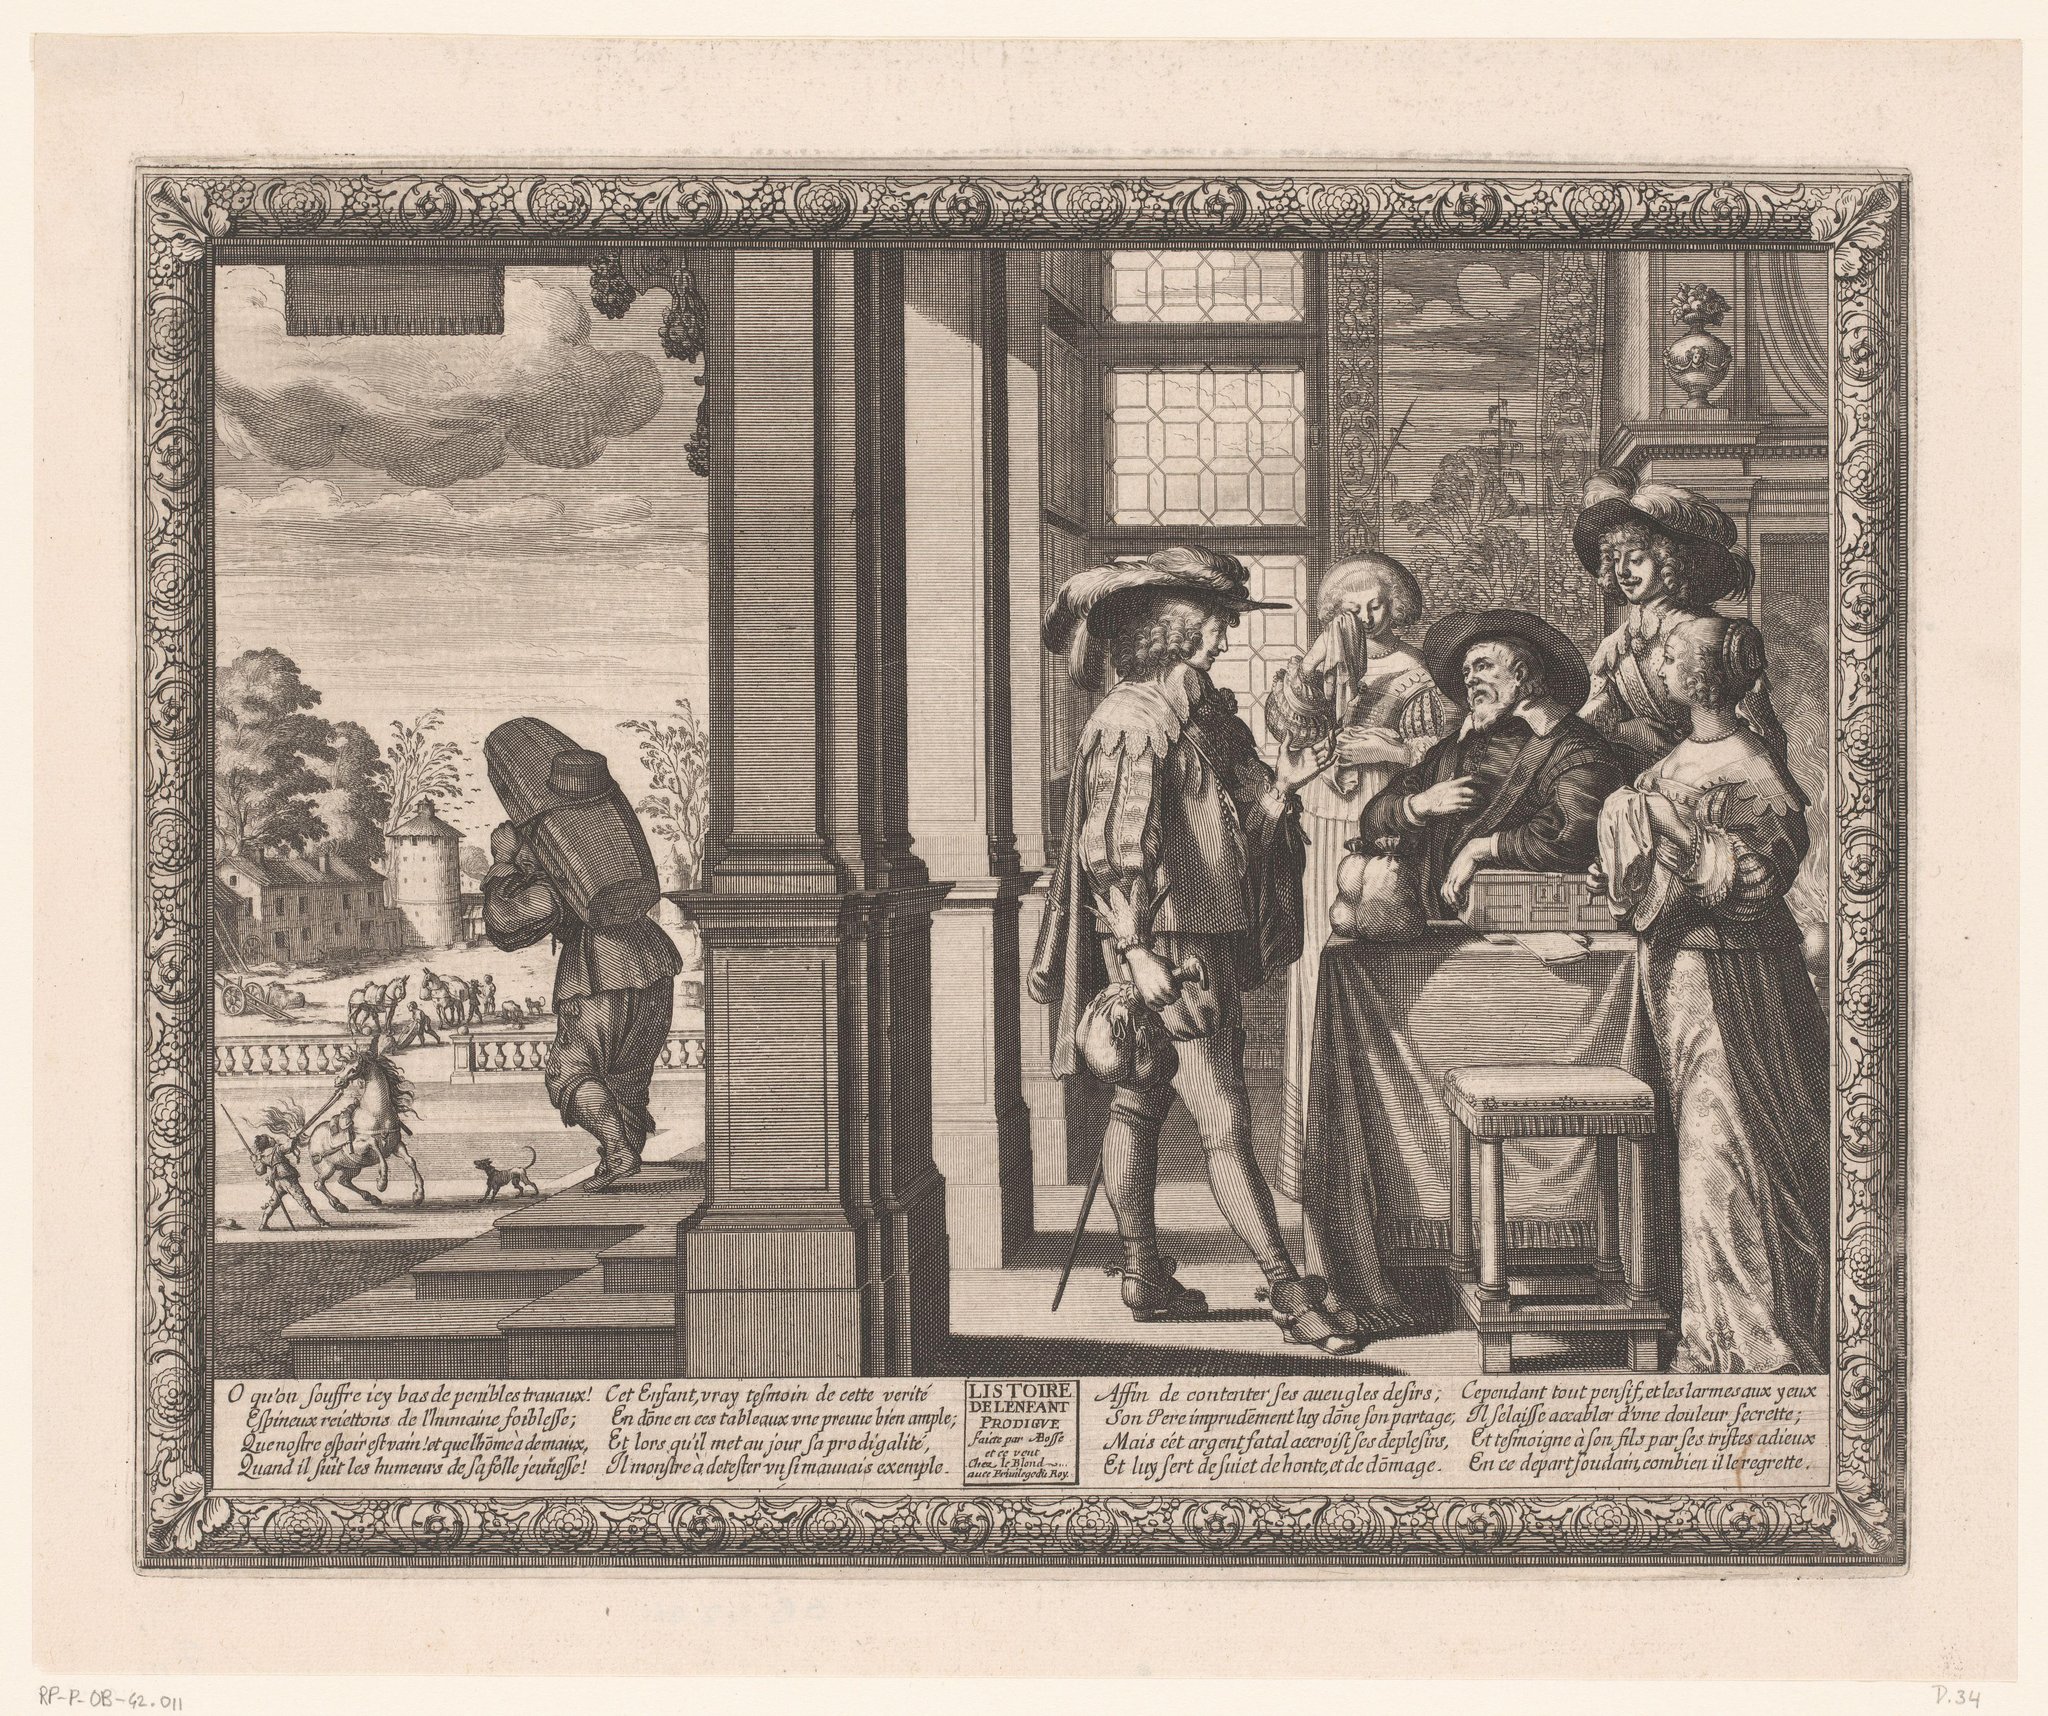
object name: print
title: Vertrek van de verloren zoon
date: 1636-1637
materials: paper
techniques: engraving, etching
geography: paris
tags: the prodigal son asks for his inheritance; his father gives him (a bag of) money, the parable of the prodigal son (luke 15:11-32), leave-taking and departure of the prodigal son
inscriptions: collector's mark: Lugt 240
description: Maakt deel uit van een serie van zes prenten met scènes uit de parabel van de verloren zoon.